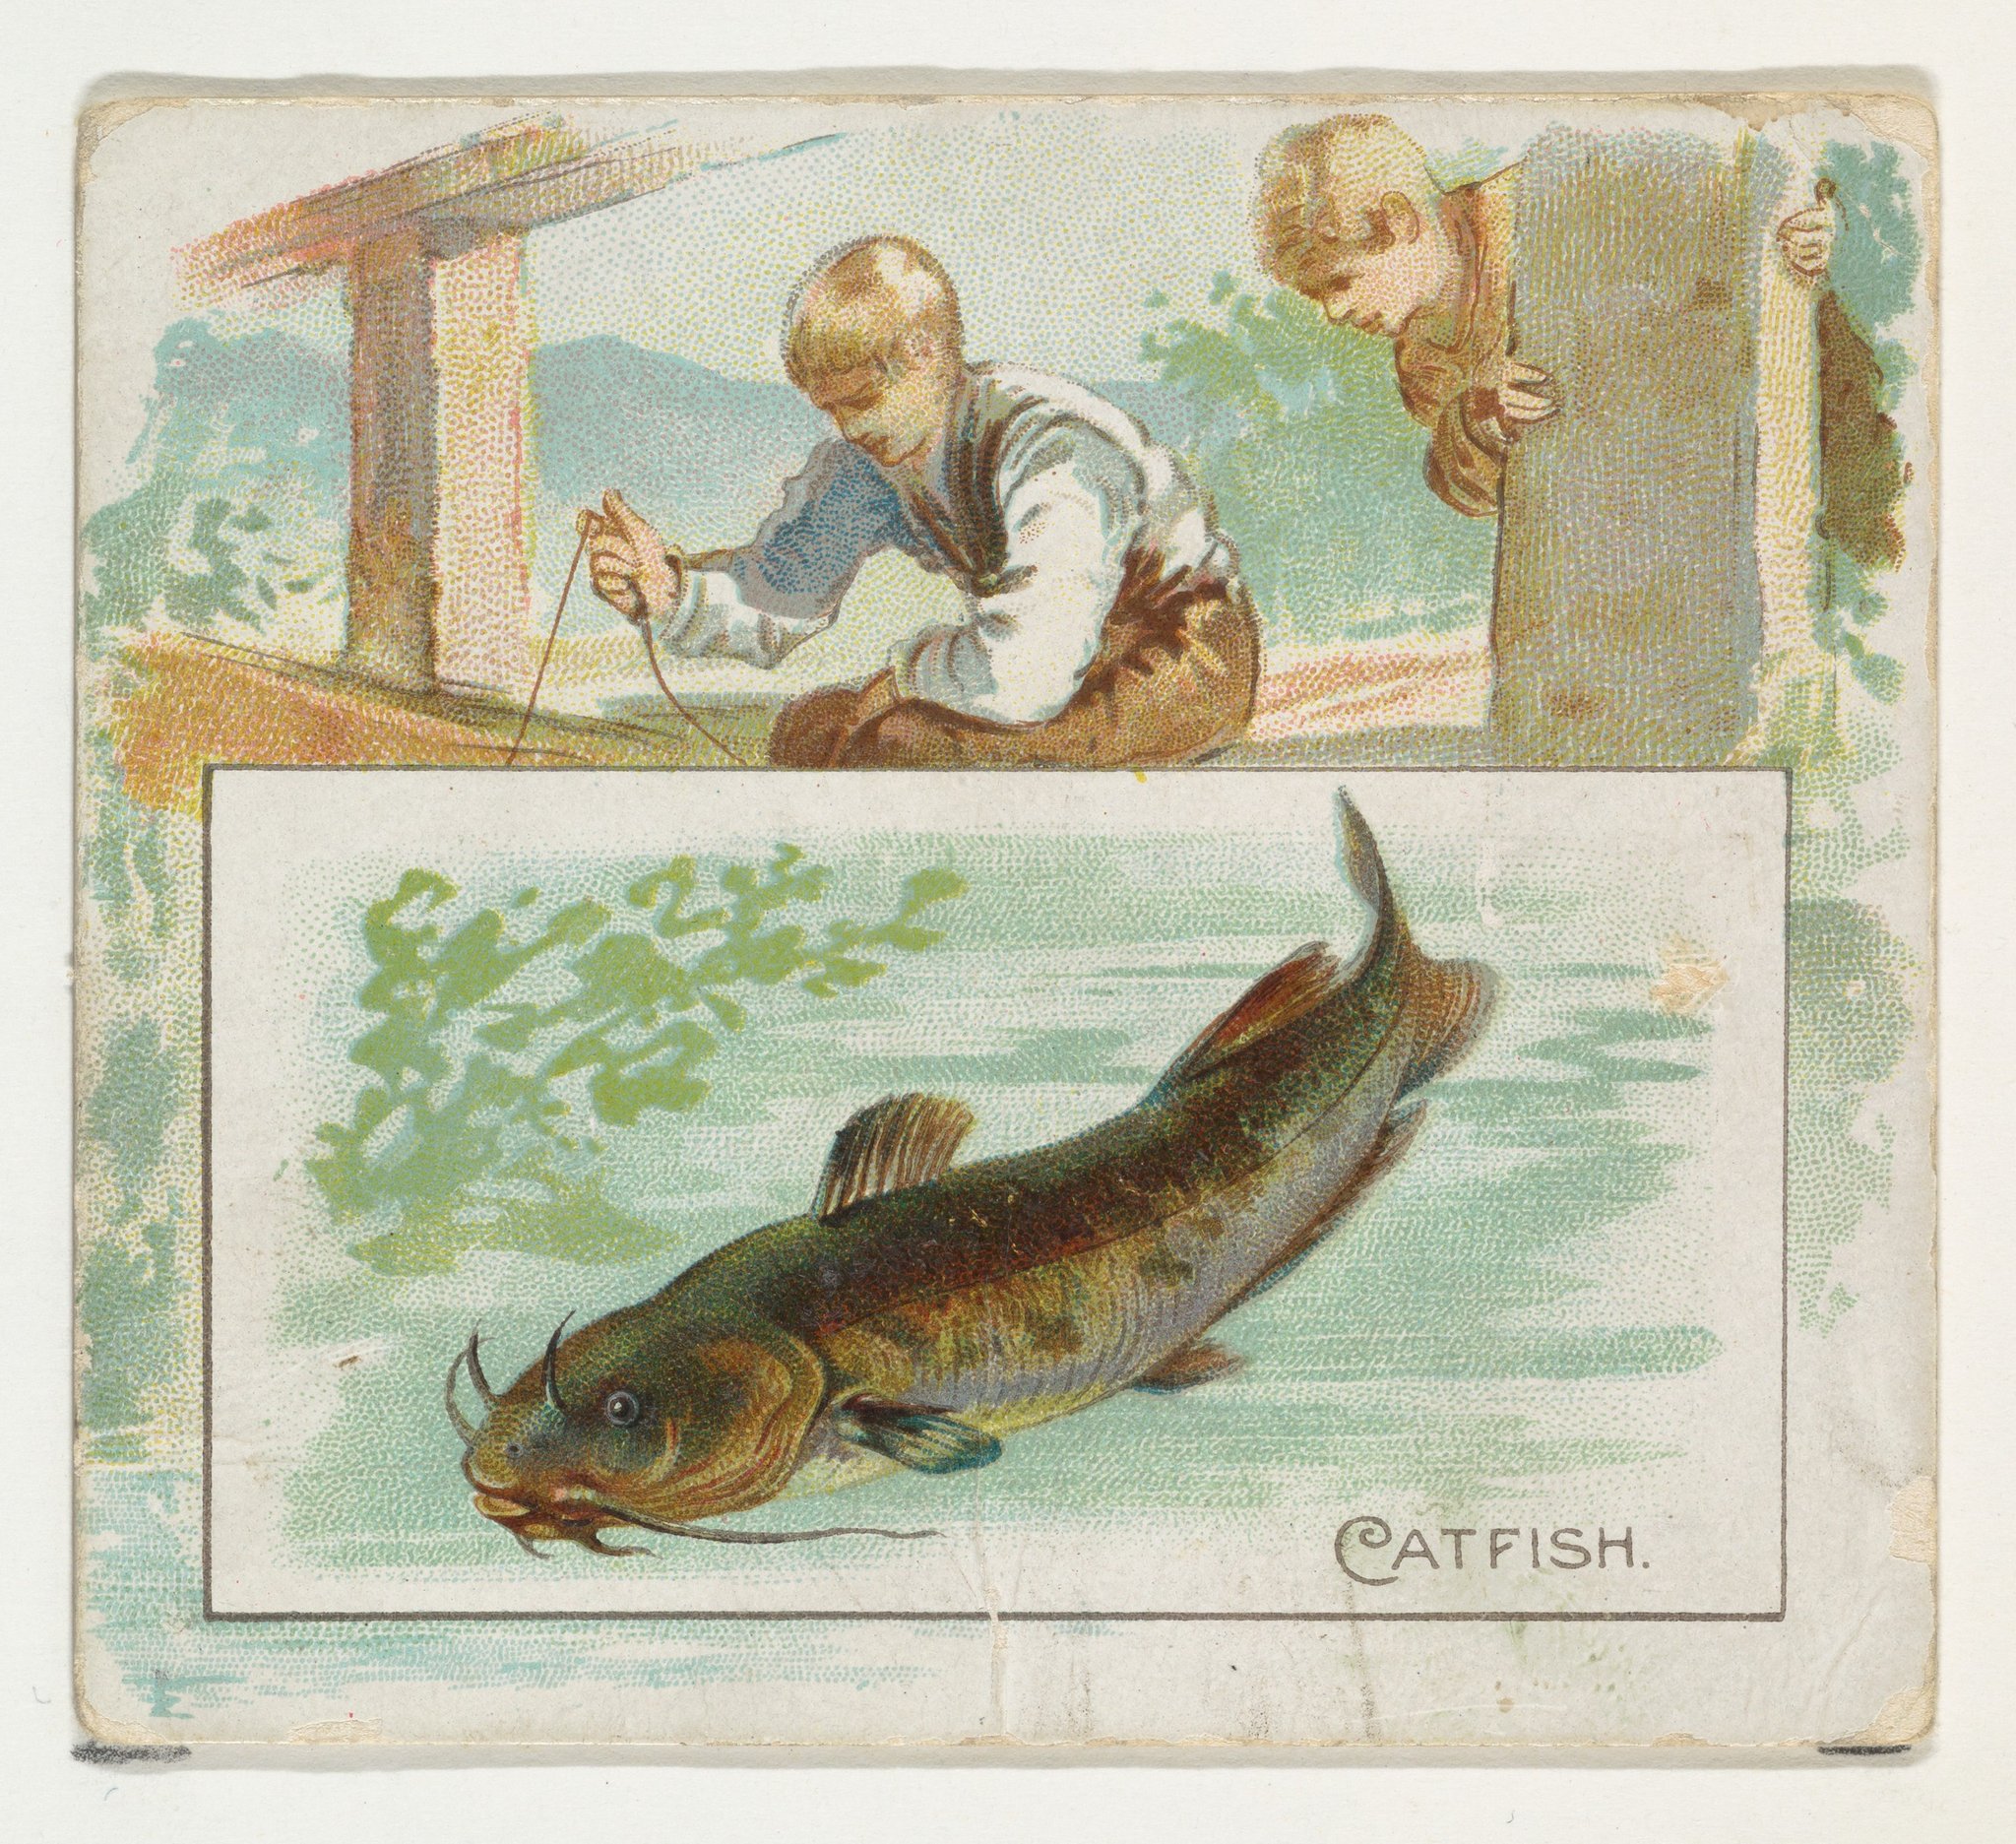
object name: print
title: Catfish, from Fish from American Waters series (N39) for Allen & Ginter Cigarettes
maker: allen & ginter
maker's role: publisher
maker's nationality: american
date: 1889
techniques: color lithograph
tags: boys,fish